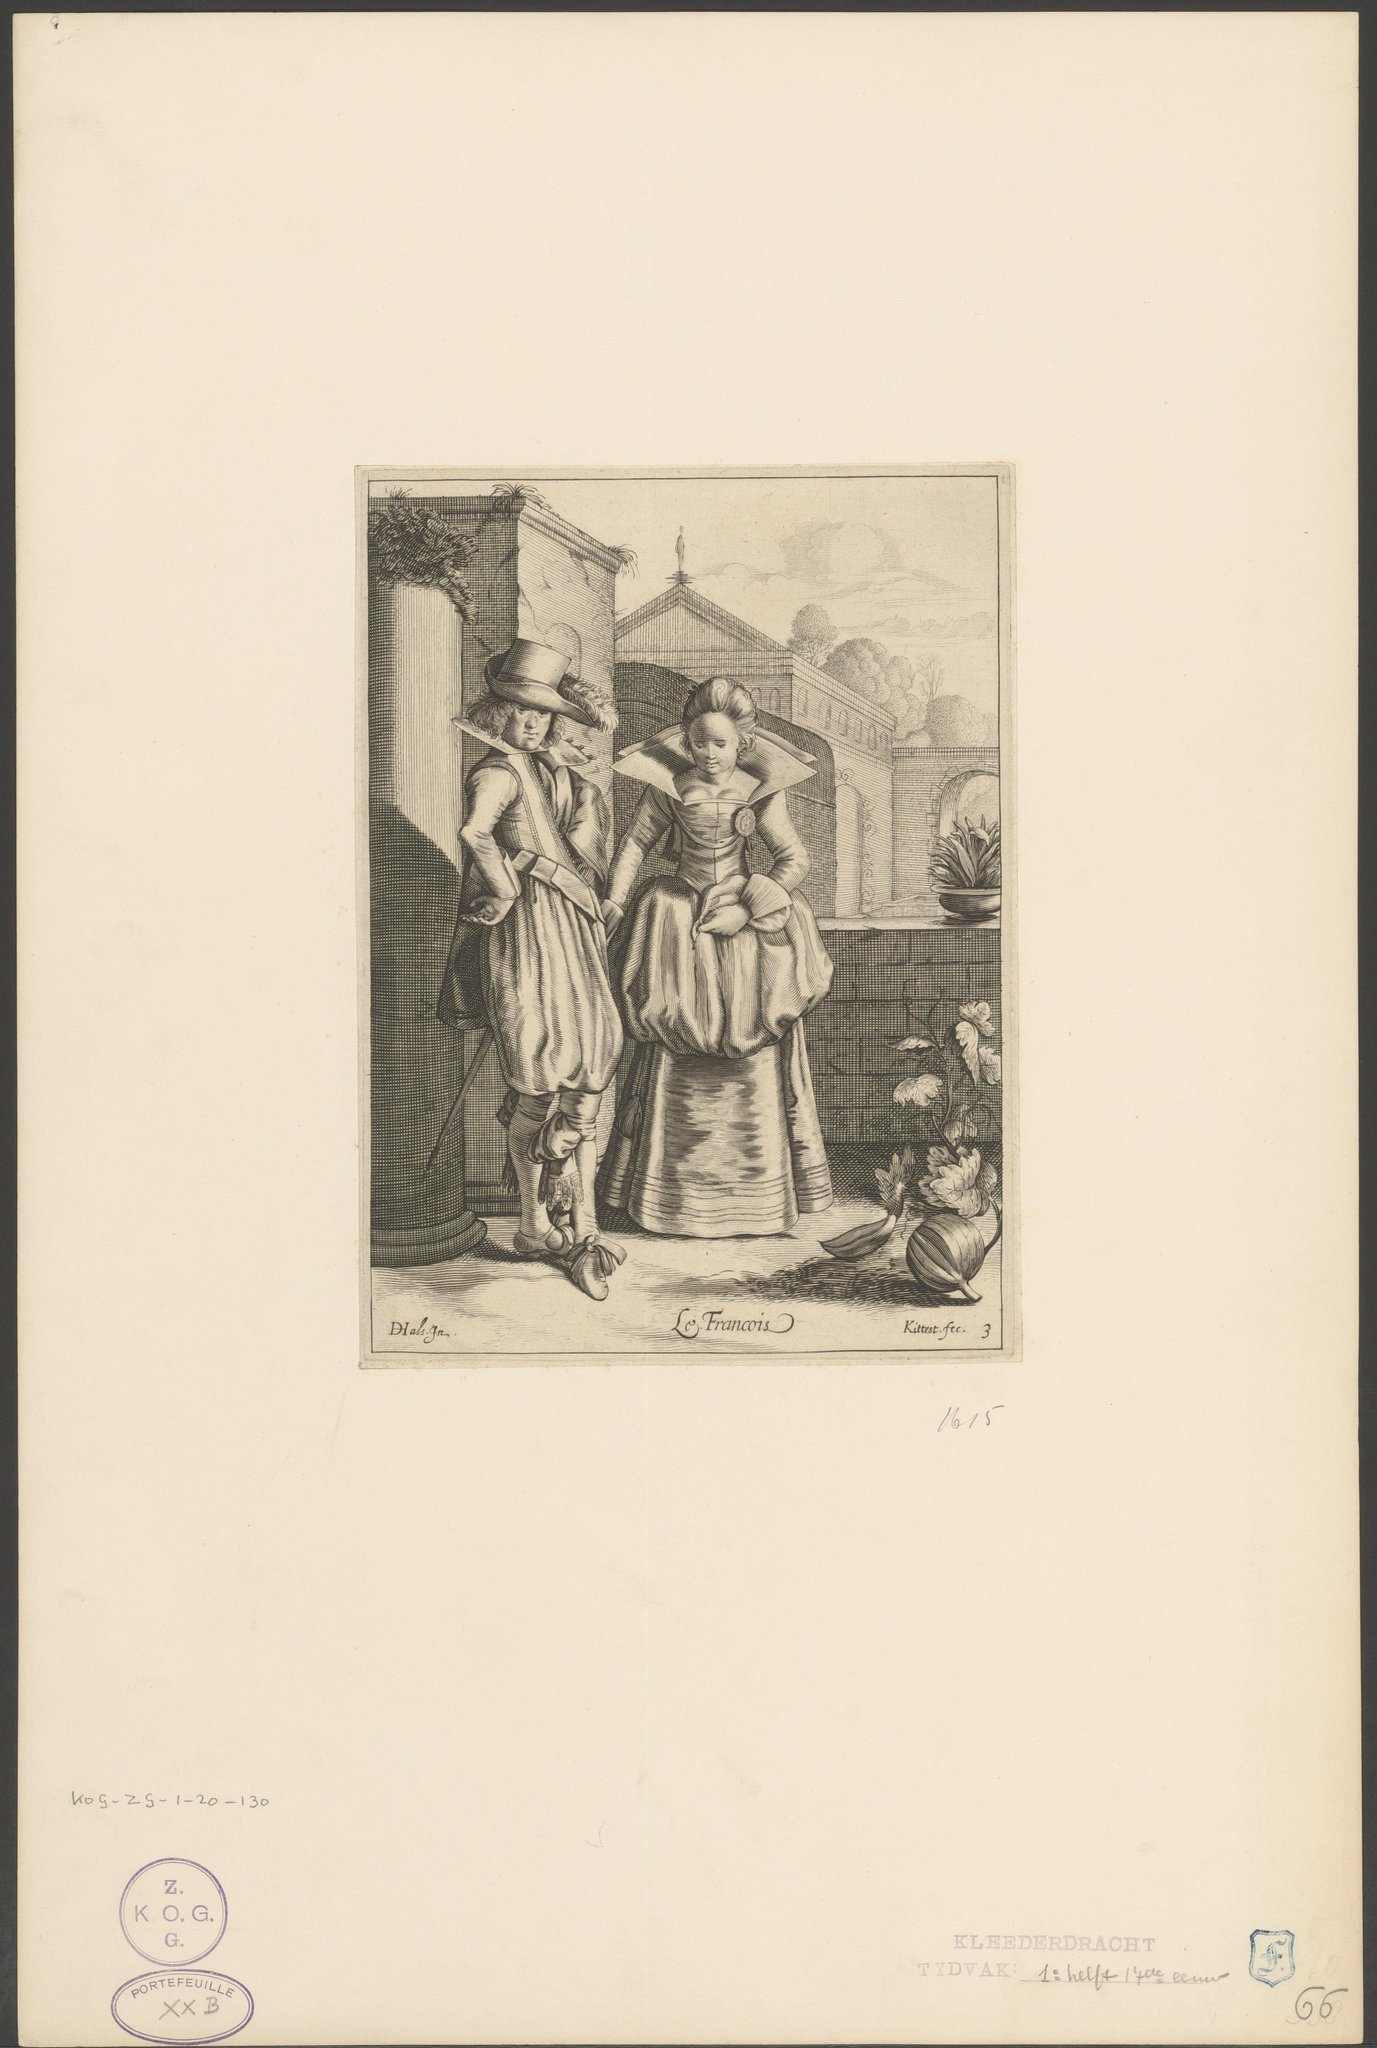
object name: print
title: Le Francois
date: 1610-1638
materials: paper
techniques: engraving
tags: handkerchief (+ women's clothes), bow (ornamental part of clothing) (+ men's clothes), cape, head-gear: hat (+ men's clothes), neck-gear: collar (+ women's clothes), head-gear: hat (+ women's clothes), europeans (with name), shoes, sandals (+ men's clothes), neck-gear: collar (+ men's clothes), trousers, breeches, etc. (breeches) (+ men's clothes), clothing for the upper part of the body (doublet) (+ men's clothes), clothing for the upper part of the body (with name) (+ women's clothes), france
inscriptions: stamp, stamp:, collector's mark: Lugt 963, collector's mark: Lugt 1641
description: Op een bordes voor een kasteel staat een elegant paar in Franse mode van ca. 1620. De bovenrok van de vrouw is, heel modieus, half opgeschort. Voor hen ligt een pompoenplant met een pompoen. Onderwerpsrubrieken binnen de Atlas Zeden en Gewoonten: Zeden en Gewoonten in Engeren Zin, De Kleeding, Kleederdrachten (tijdvakken), Het begin der 17de eeuw. (De Fransche mode).